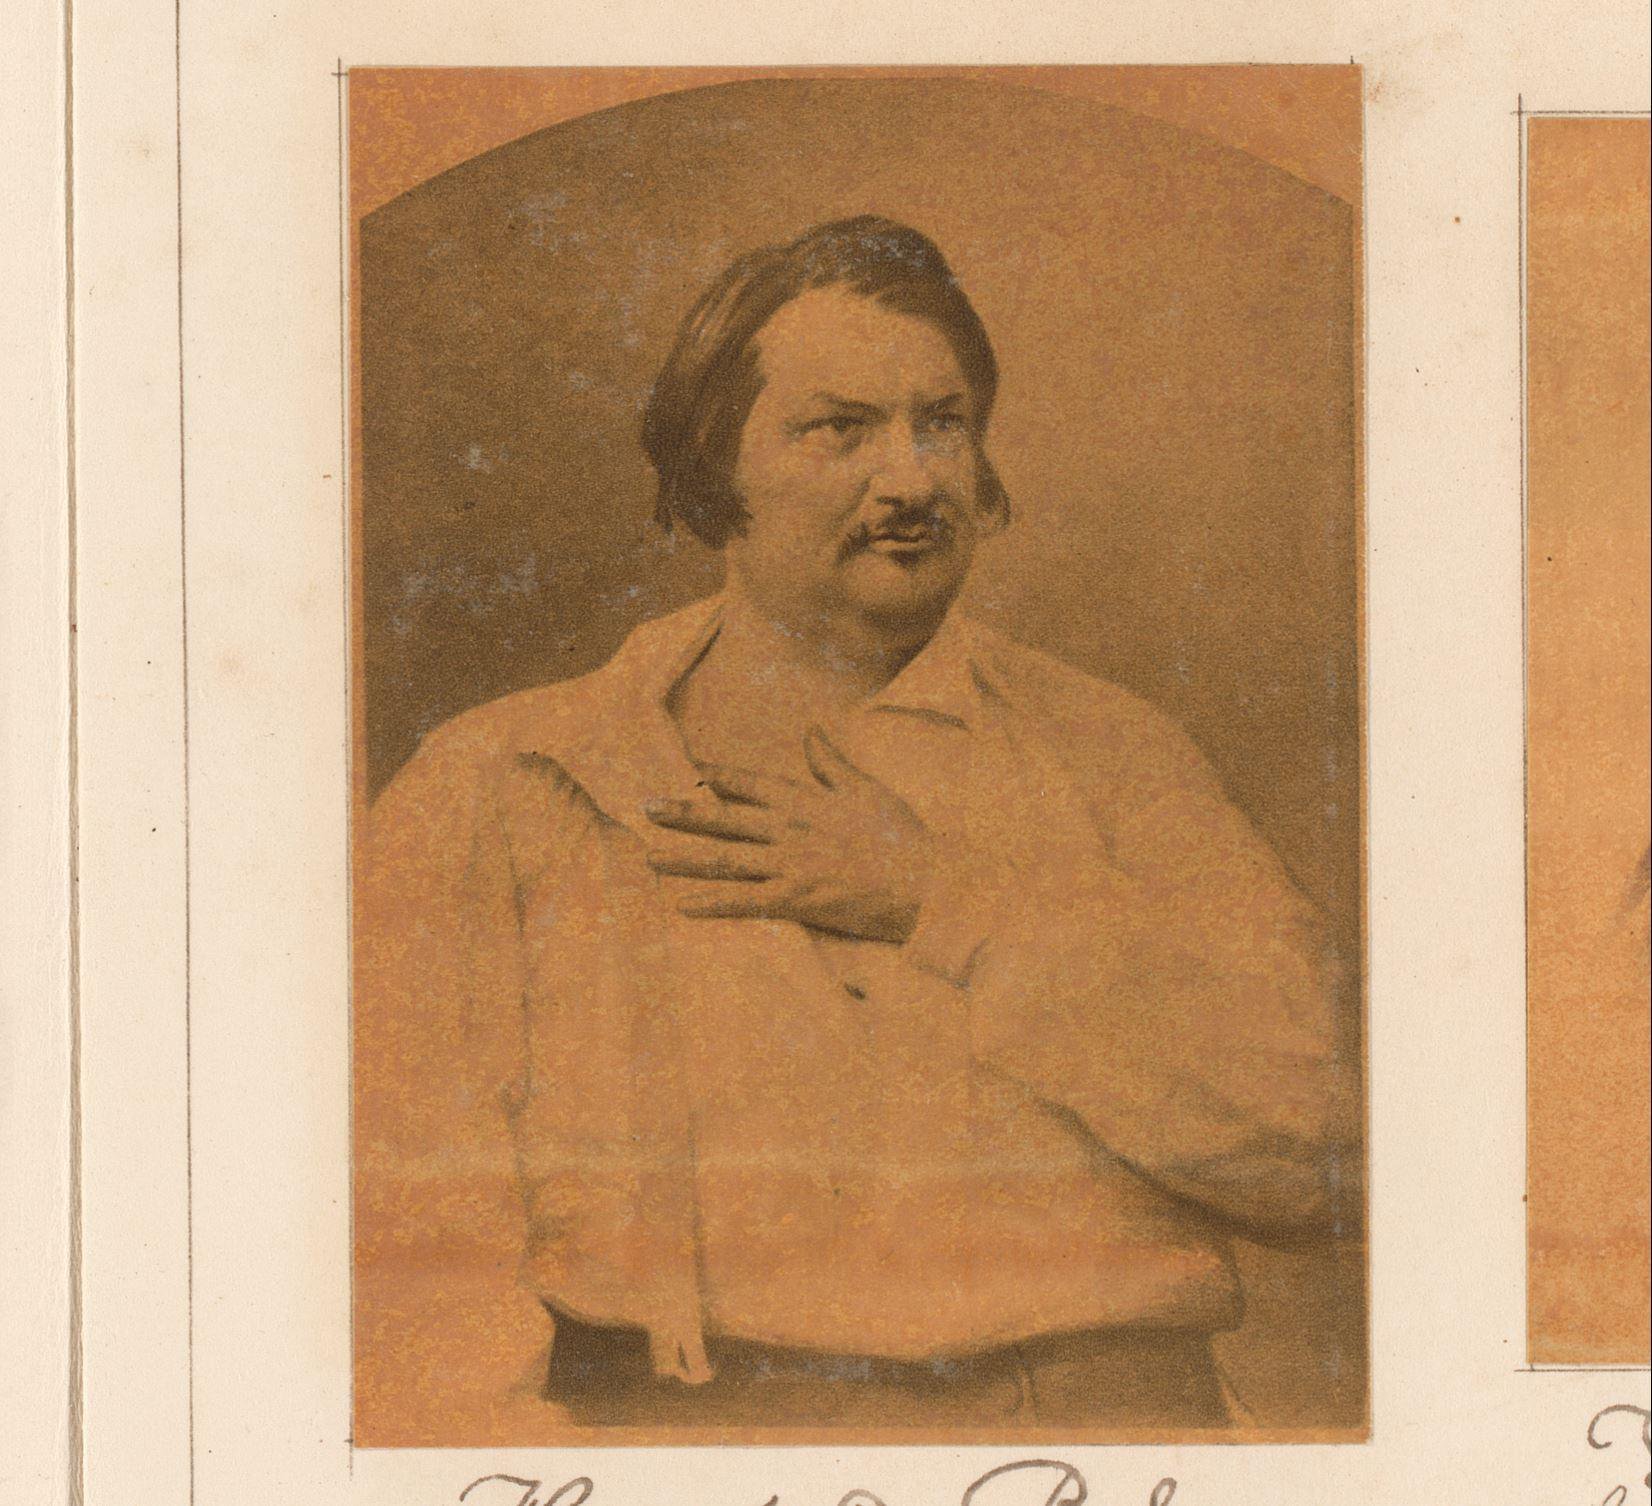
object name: album leaf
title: Portret van Honoré de Balzac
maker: Anonymous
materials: paper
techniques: rotogravure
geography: france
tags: paris, honoré de balzac, portrait of a writer, france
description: Deze prent maakt deel uit van een album.